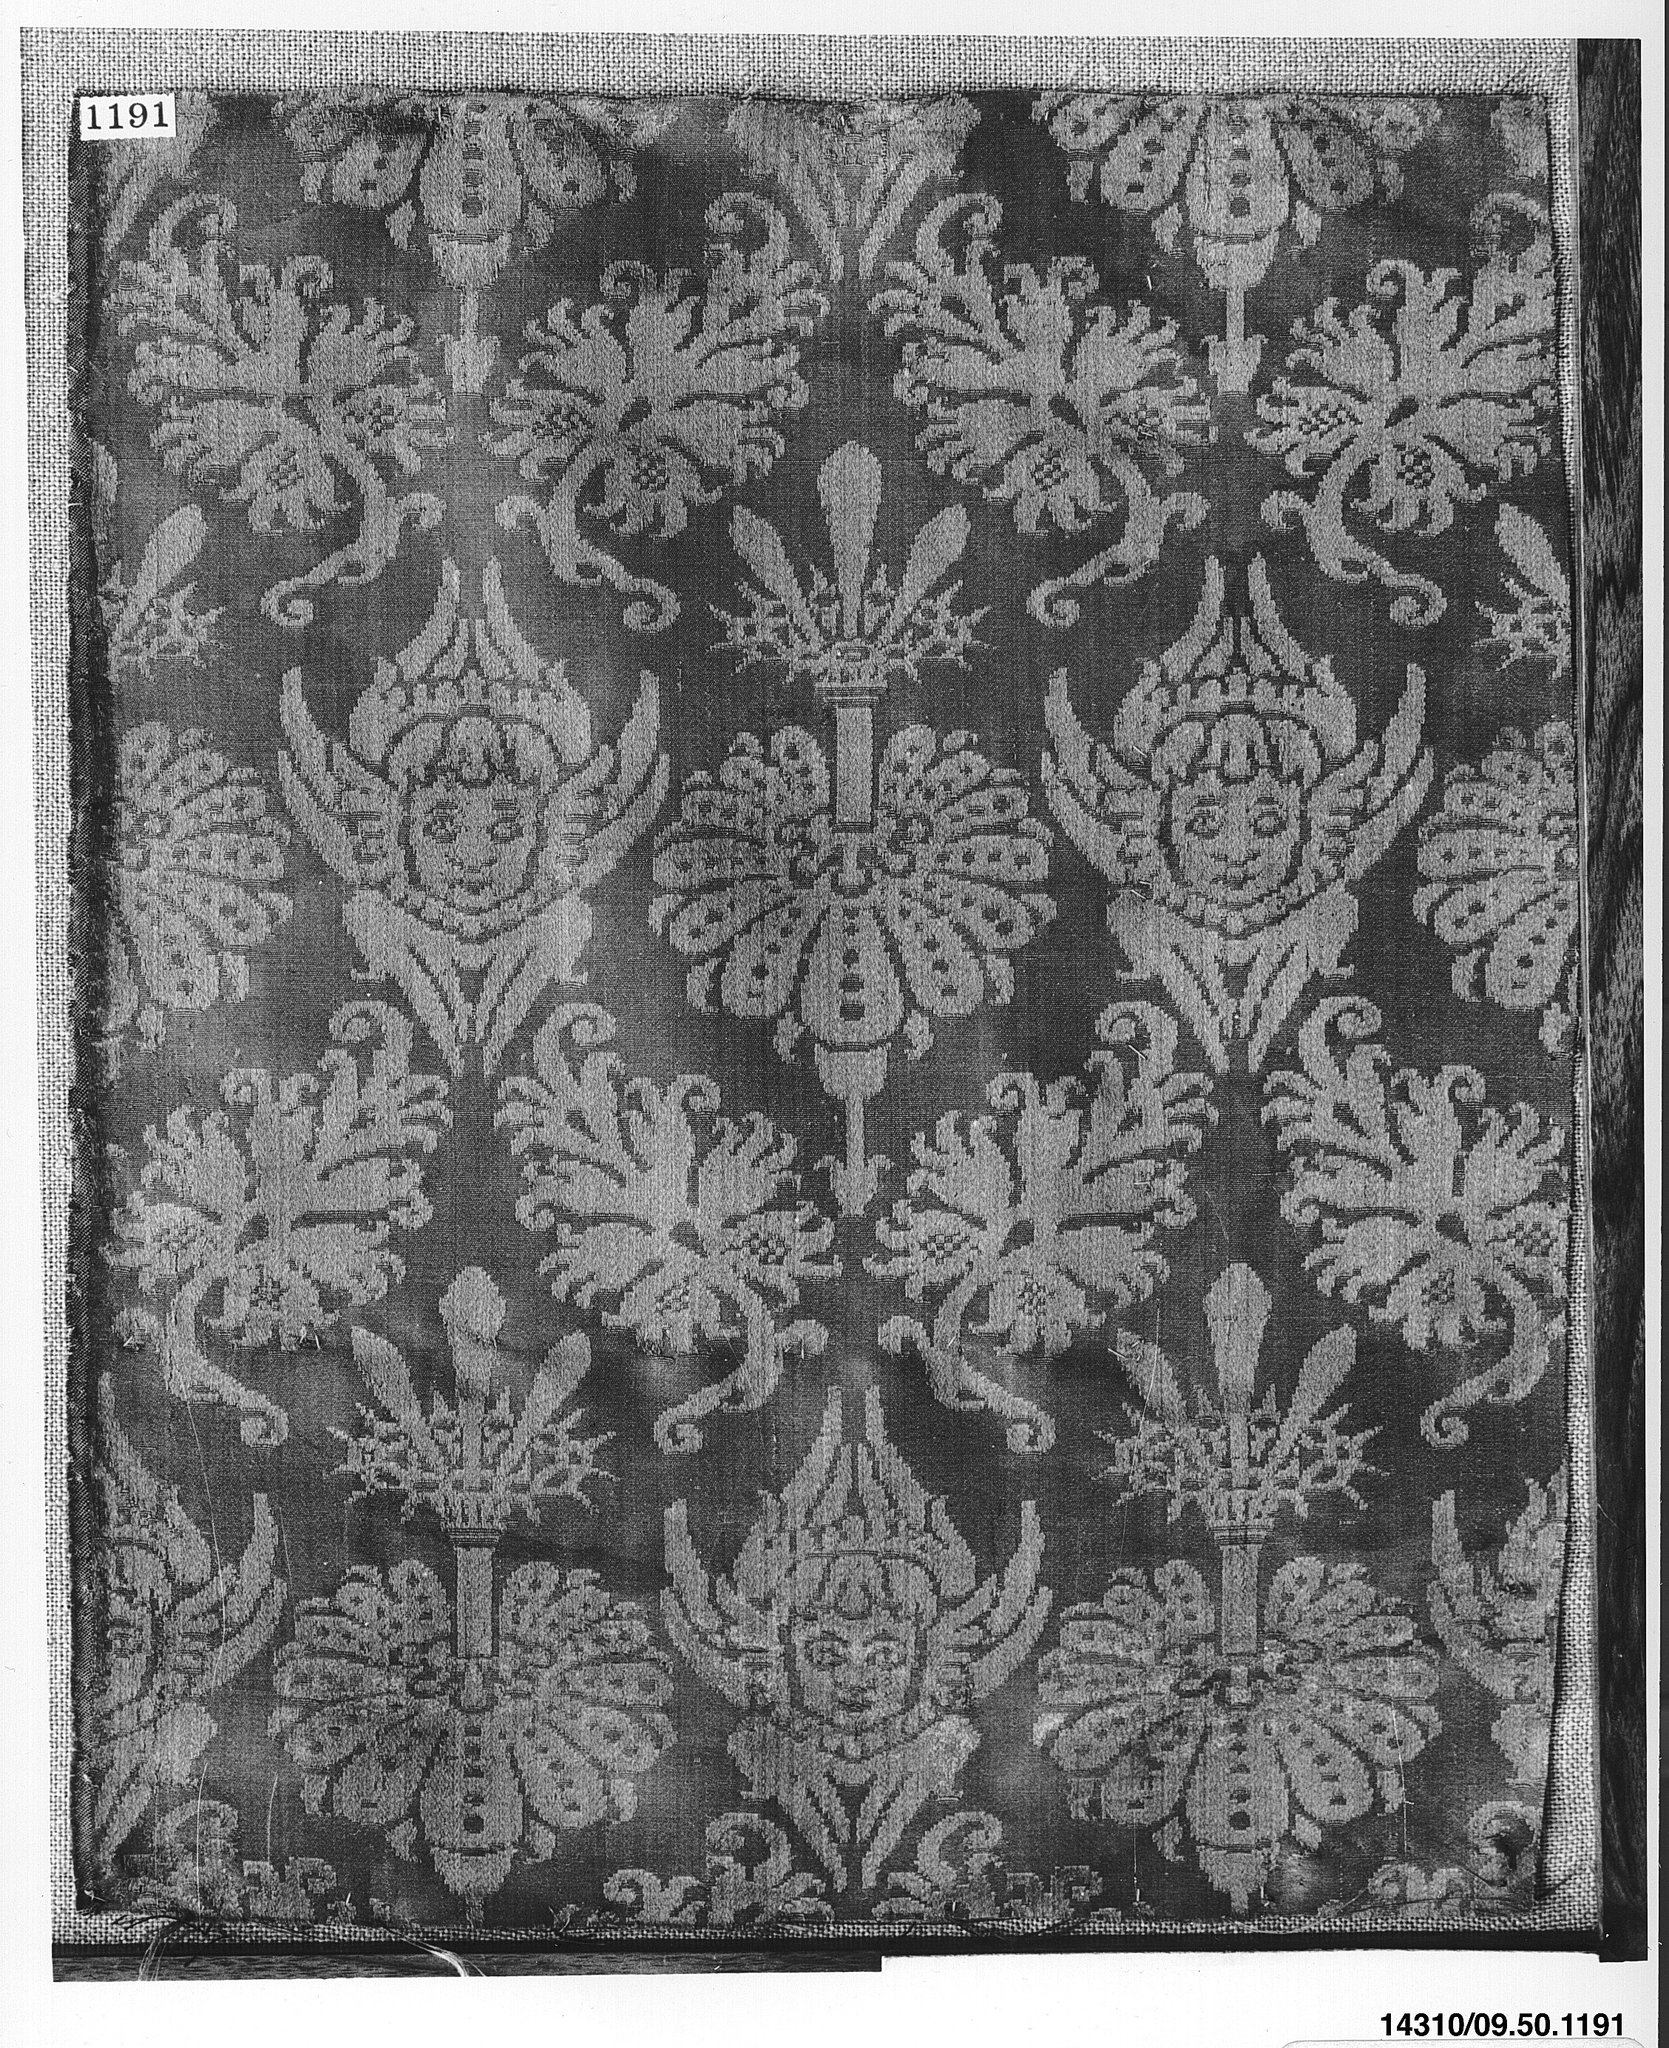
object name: piece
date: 1501-1600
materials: silk